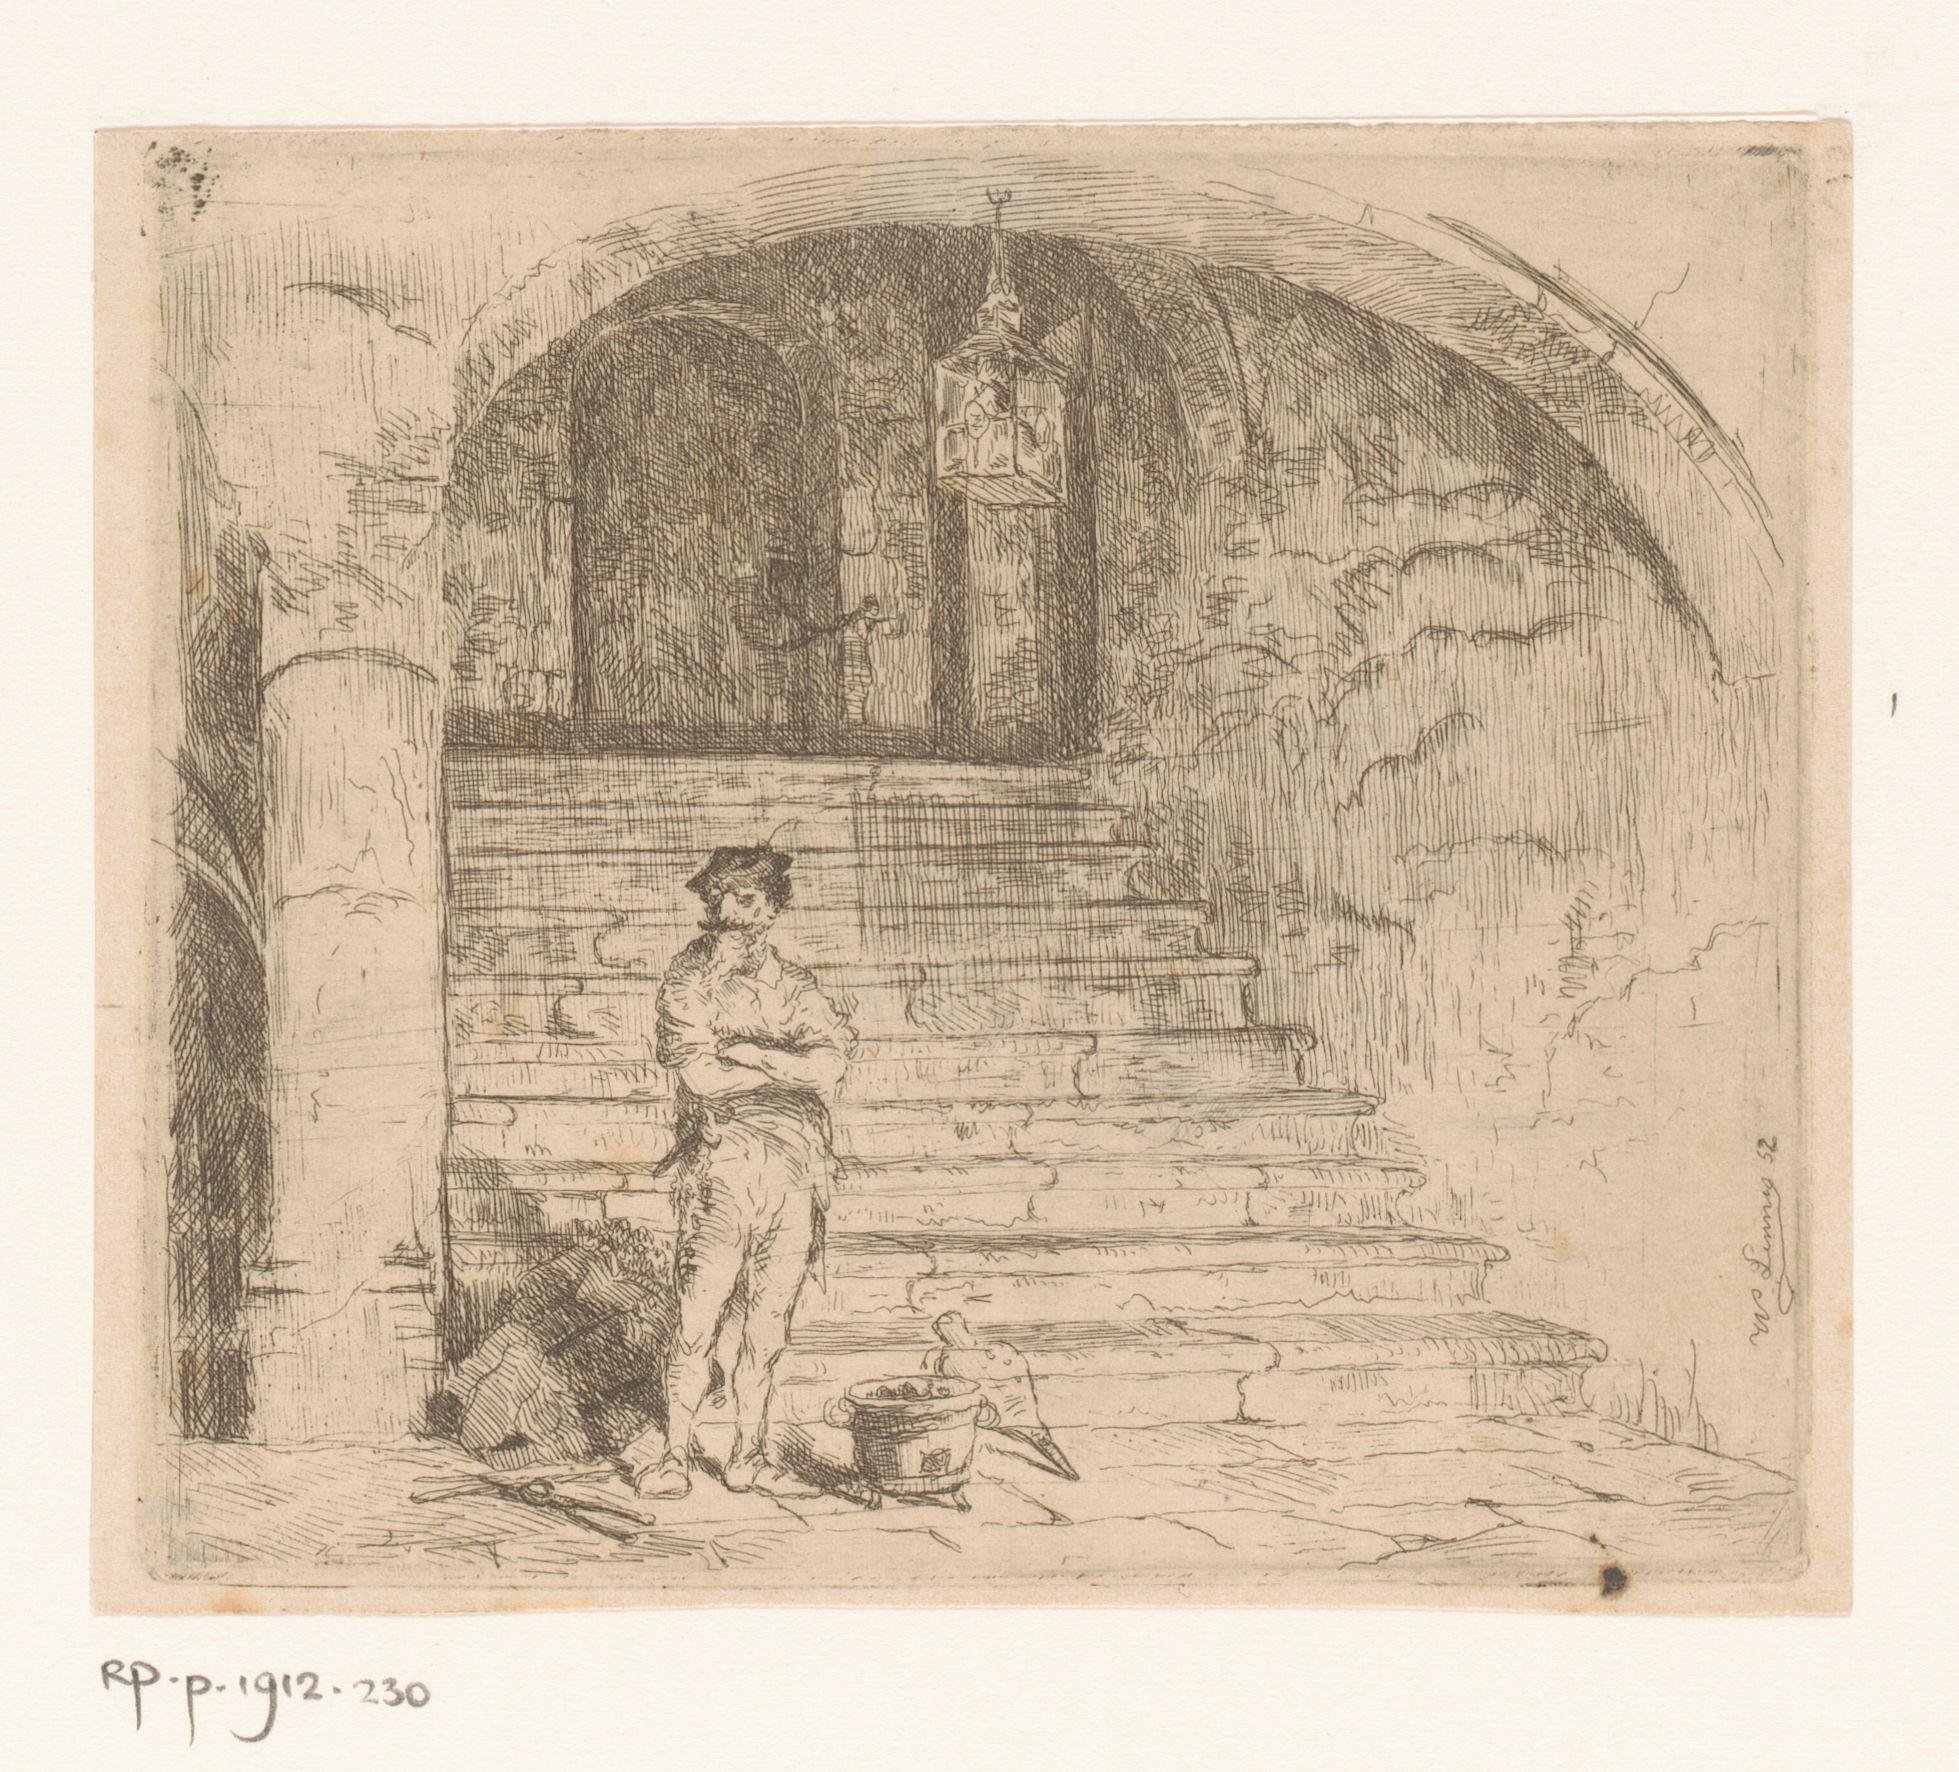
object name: print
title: Man staat naast een ketel bij een trap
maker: willem linnig (i)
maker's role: print maker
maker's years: 1819-1885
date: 1852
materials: paper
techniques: etching, intaglio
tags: adult woman, staircase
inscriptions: collector's mark: Lugt 1485, collector's mark: Lugt 2228